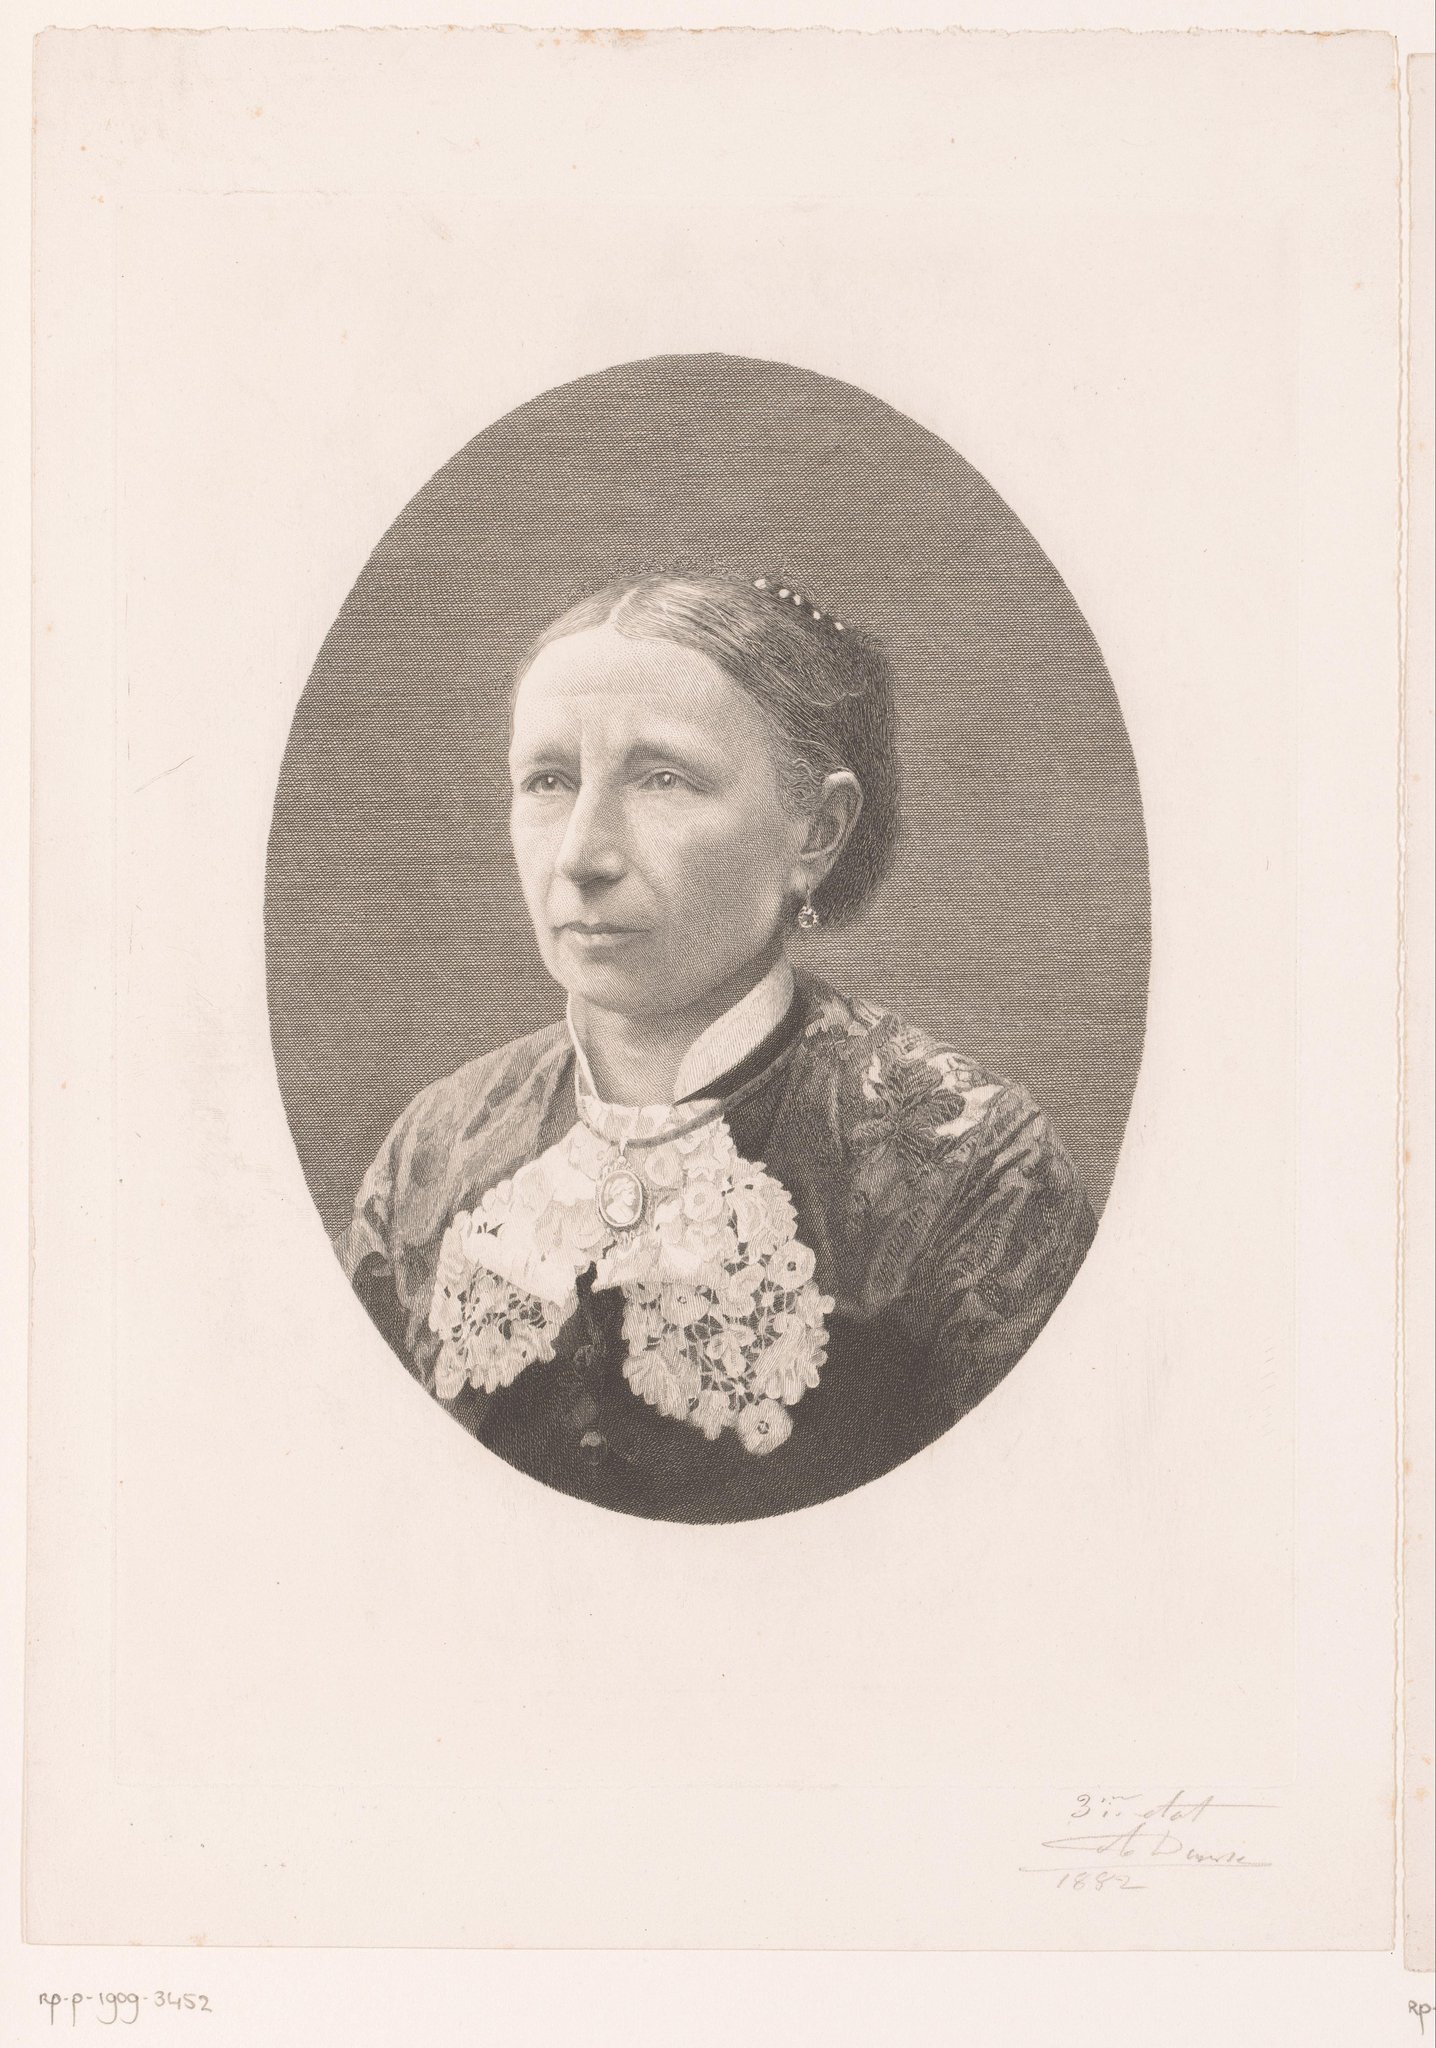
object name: print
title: Portret van een onbekende vrouw, mogelijk mevrouw Boulez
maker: auguste danse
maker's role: print maker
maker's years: 1829-1929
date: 1882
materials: paper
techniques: etching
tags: anonymous historical person portrayed alone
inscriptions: annotation: ‘3me état’, collector's mark: Lugt 2228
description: De identificatie madame Boulez is gebaseerd op een potloodaantekening in de marge van een eerdere staat van deze prent in de collectie van het Rijksmuseum Amsterdam.